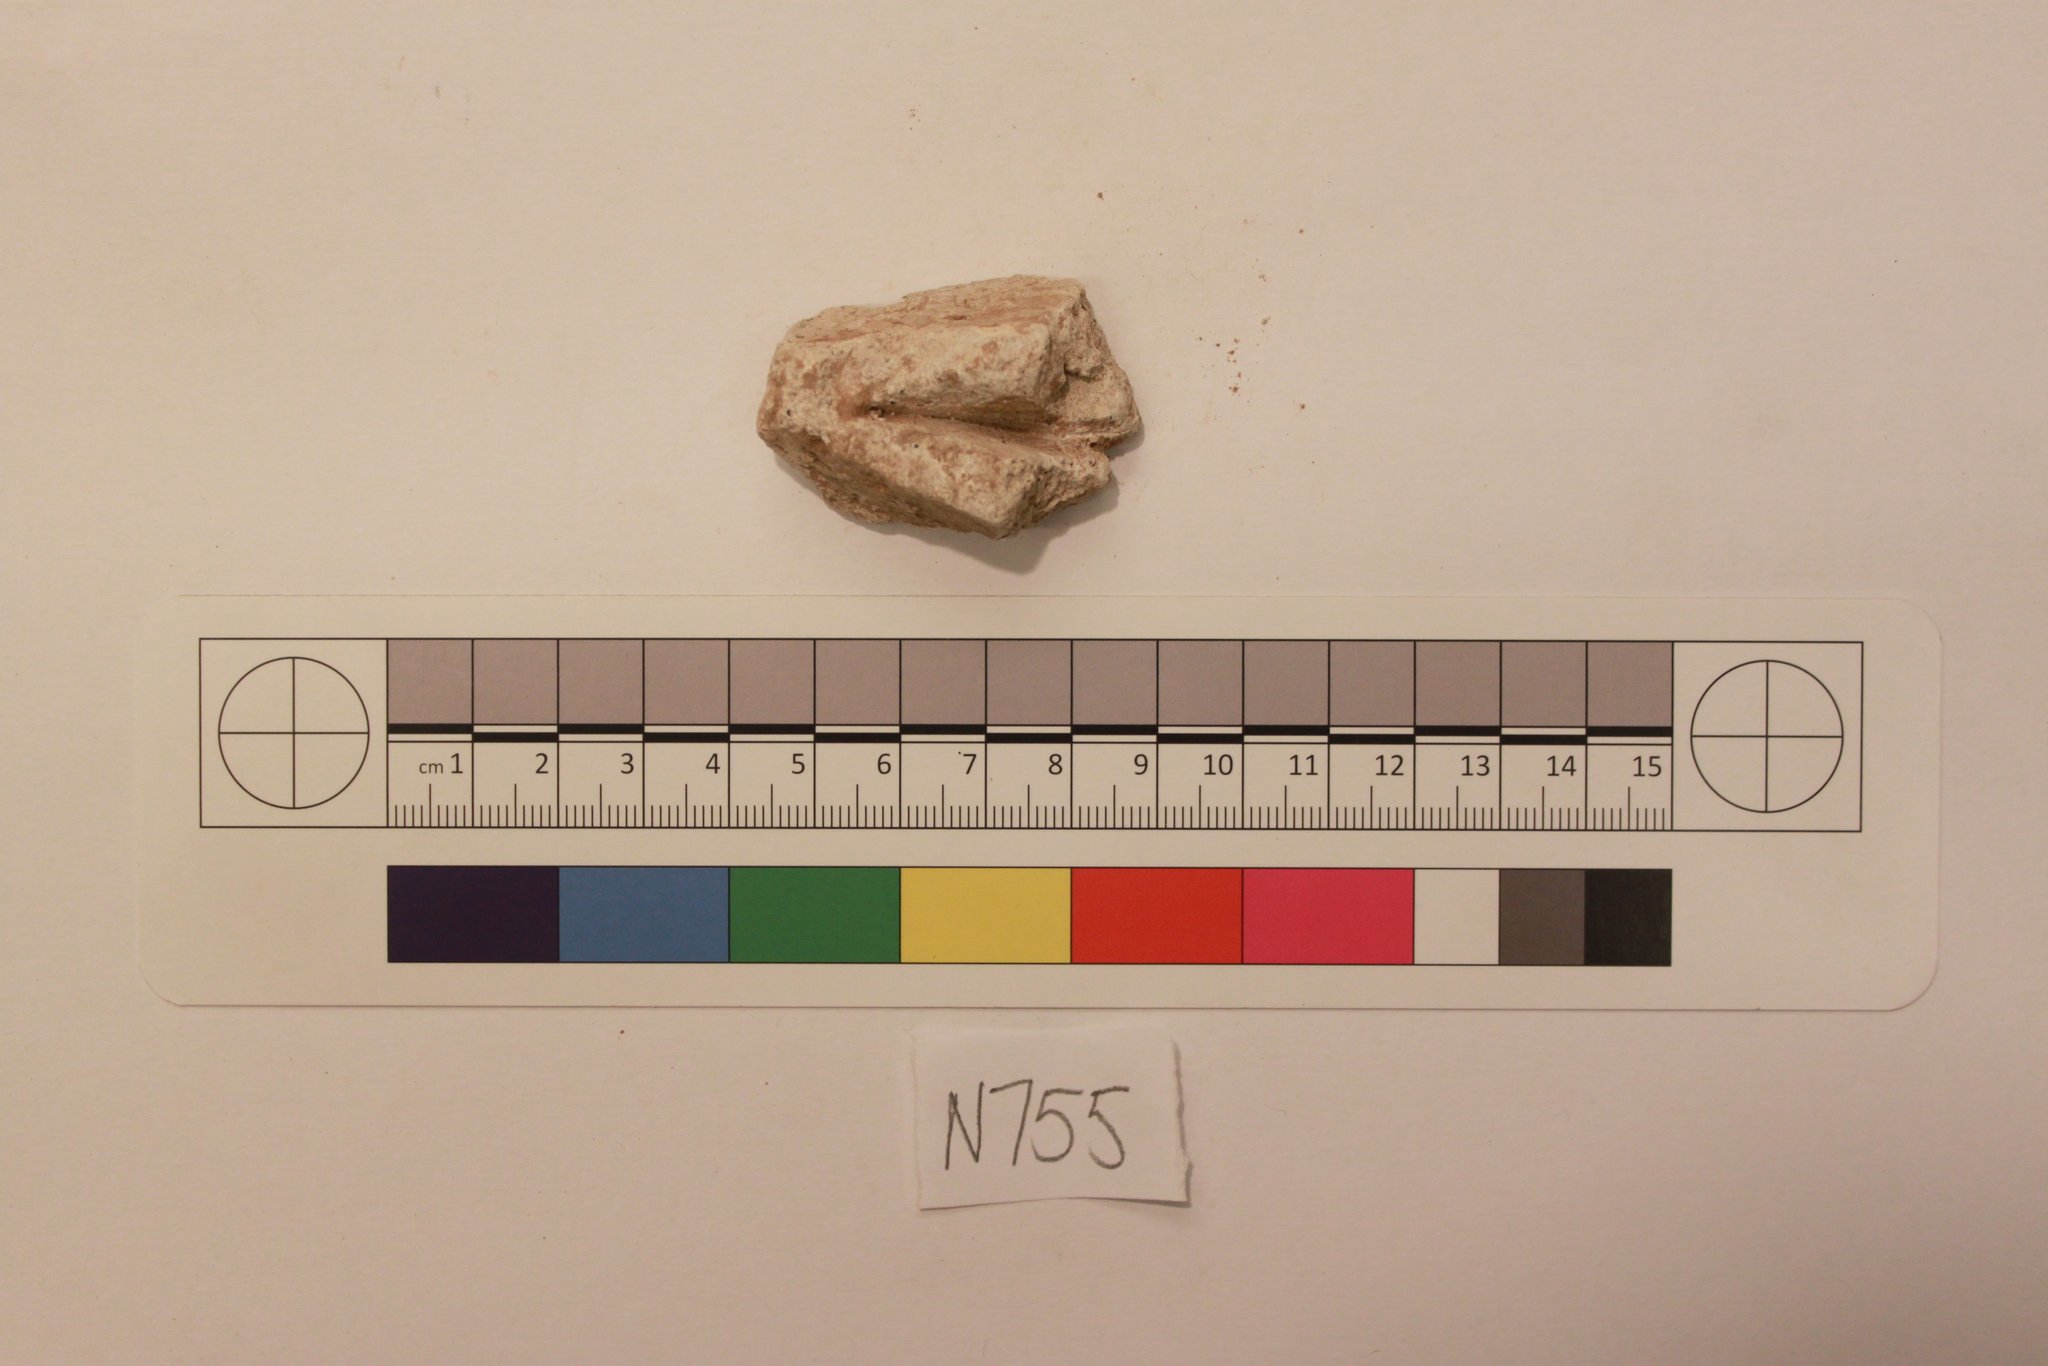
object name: fragment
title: Stucco Fragment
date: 701-1200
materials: plaster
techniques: carving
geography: iran